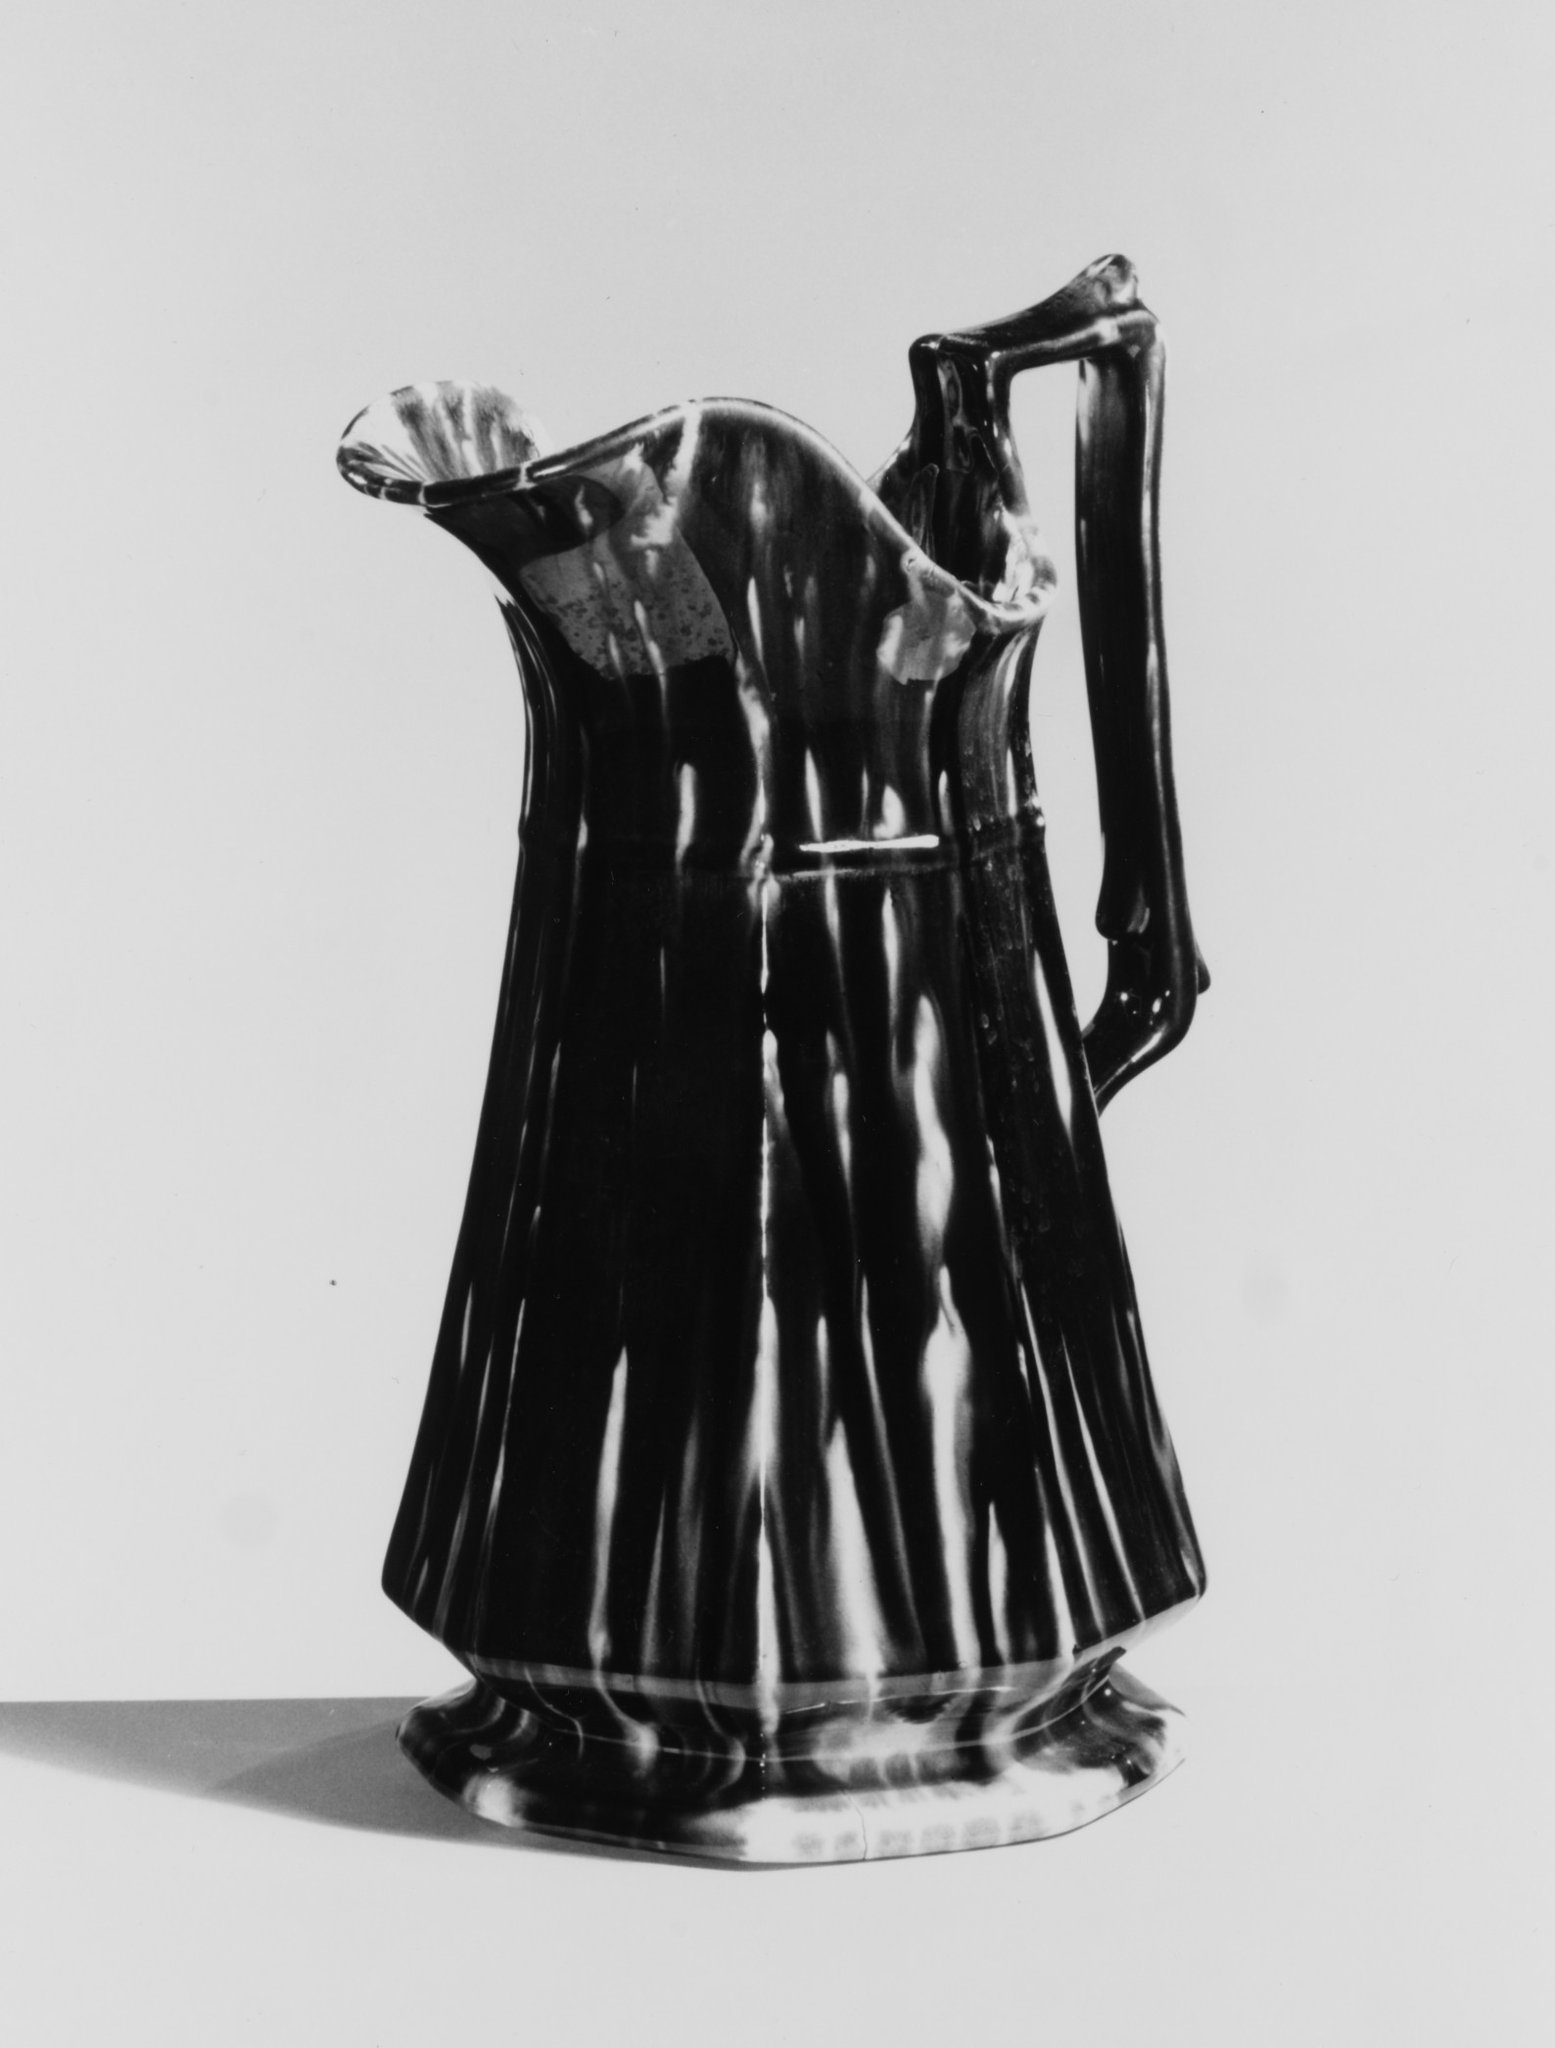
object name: pitcher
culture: american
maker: lyman, fenton & co.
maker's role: maker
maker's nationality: american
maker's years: 1849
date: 1849-1858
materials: earthenware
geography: united states